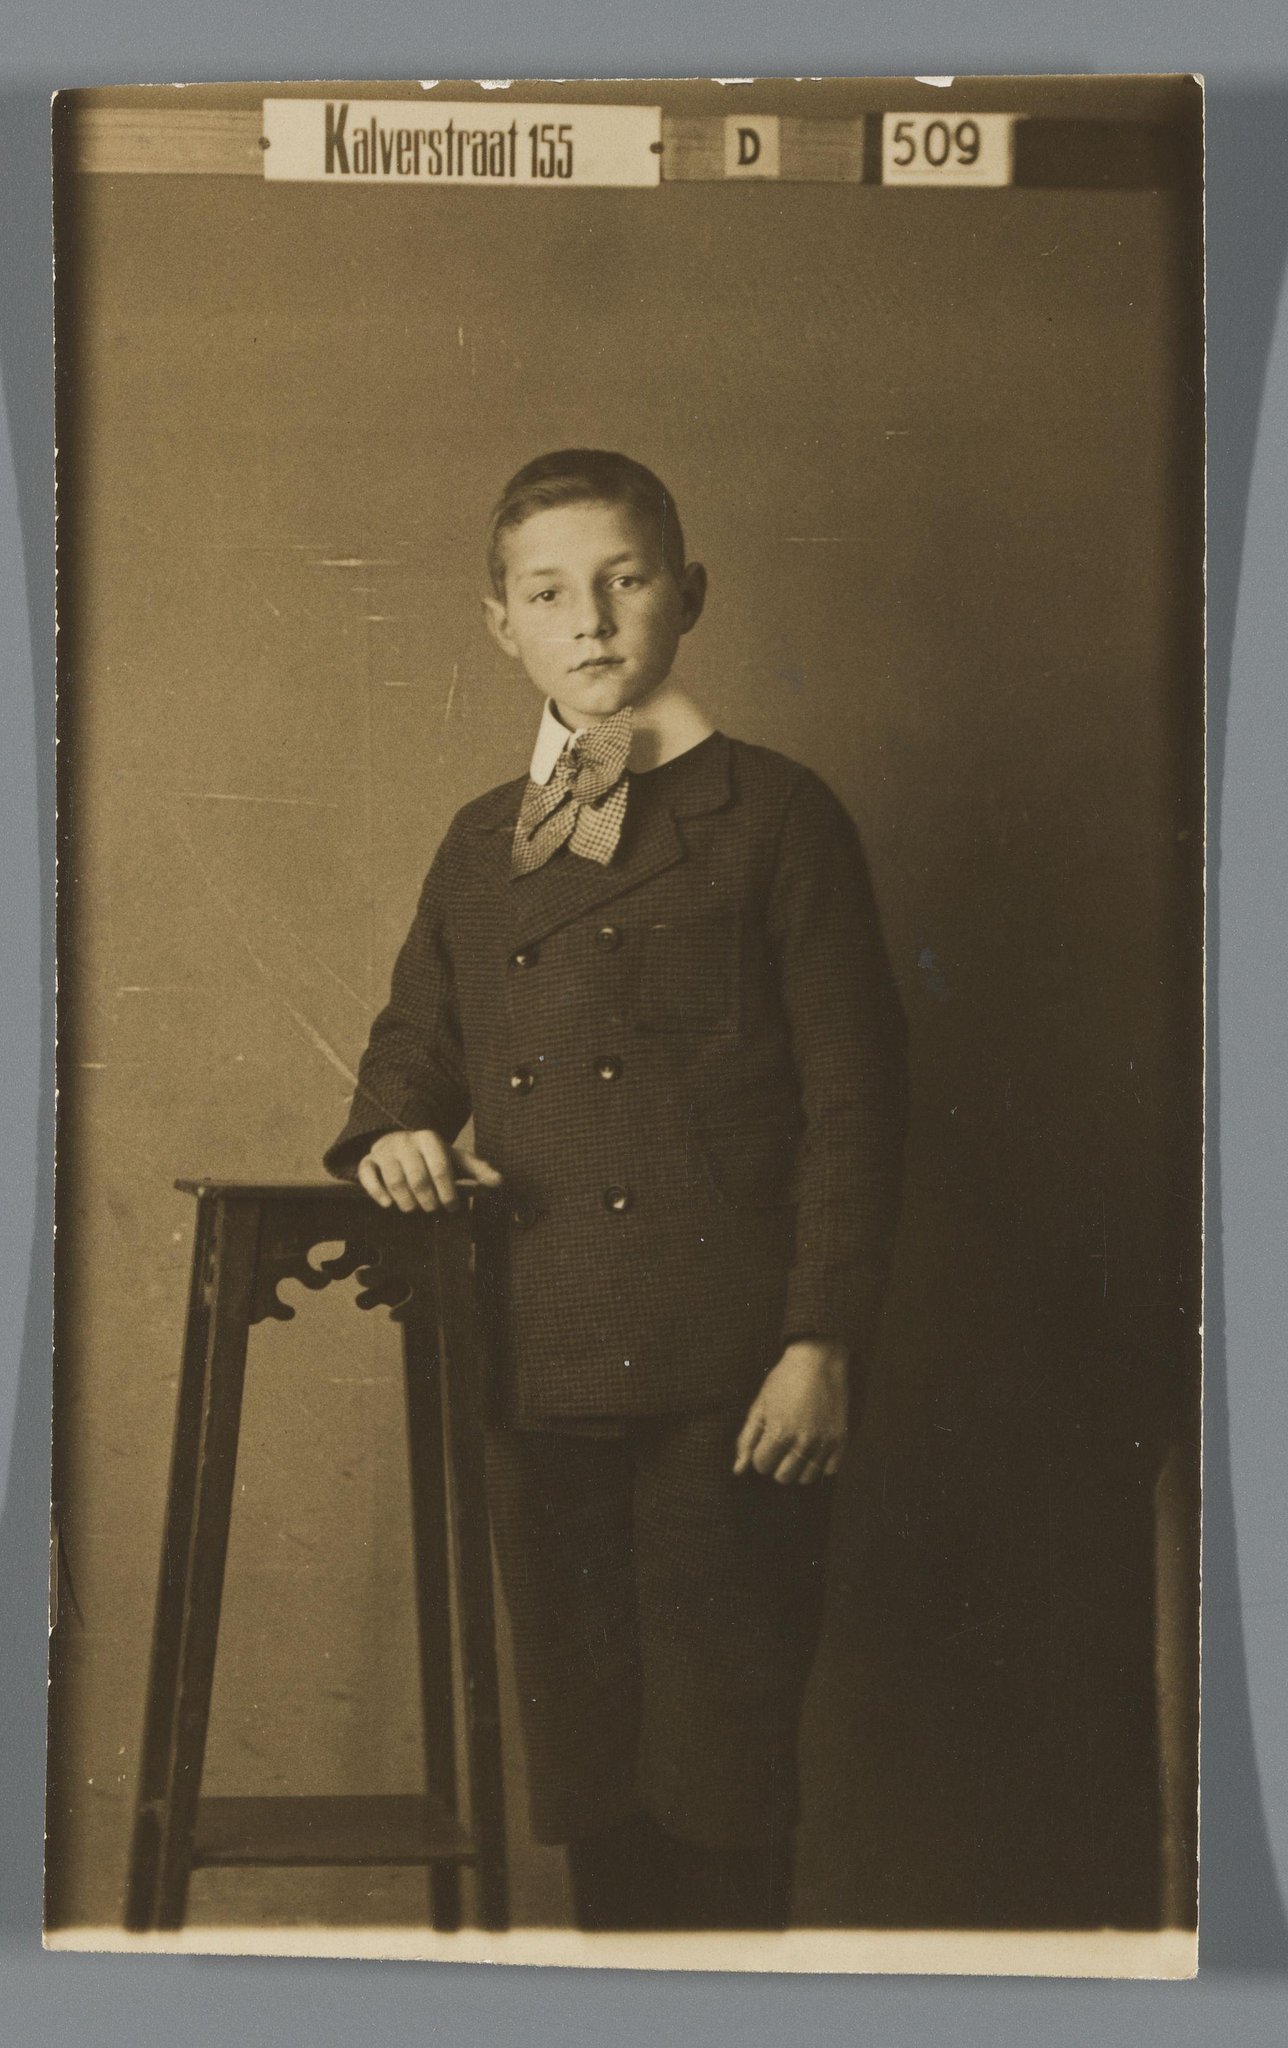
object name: snapshot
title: Portret van een onbekende jongen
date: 1913-1925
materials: photographic support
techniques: gelatin silver print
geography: amsterdam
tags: amsterdam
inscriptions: inscription: ‘Kalverstraat 155 Nr. D509’